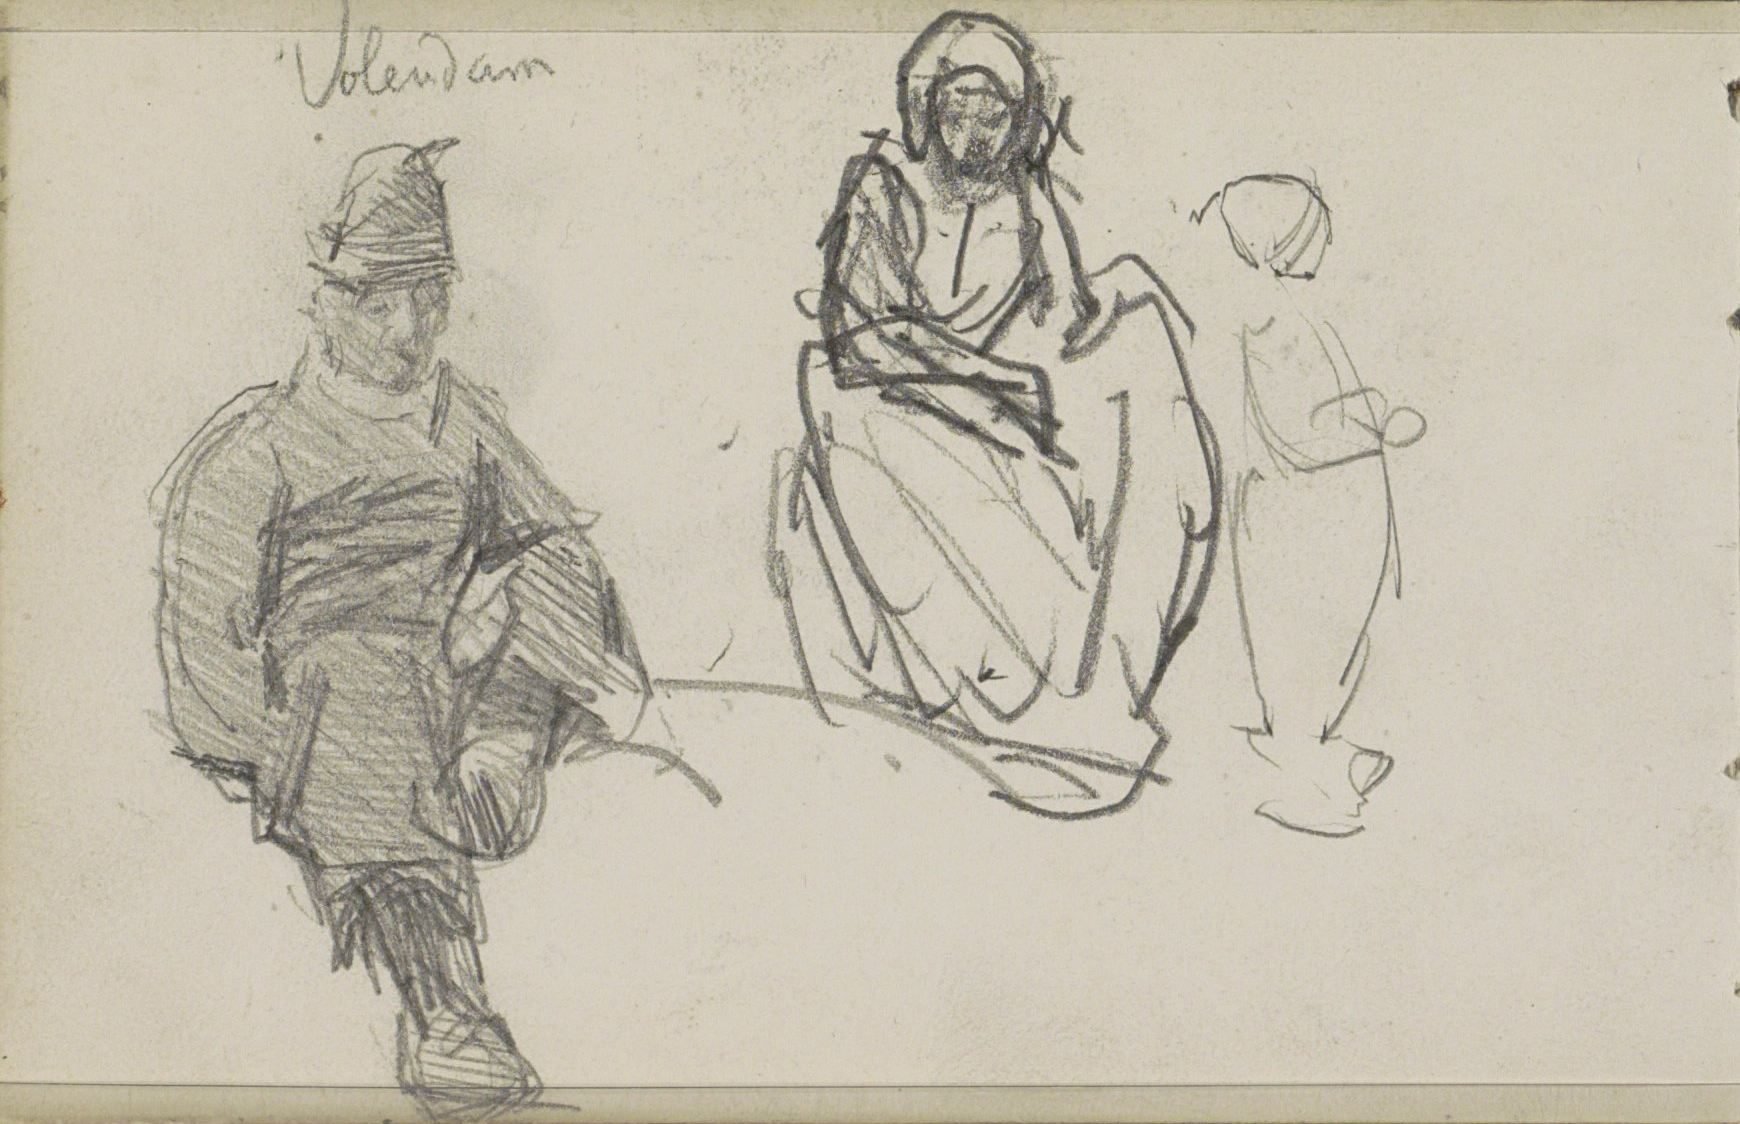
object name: sketchbook leaf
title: Zittende man en een vrouw met kind in Volendamse klederdracht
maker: george clausen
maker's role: draughtsman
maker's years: 1852-1912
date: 1875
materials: paper, pencil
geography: volendam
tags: adult woman, adult man, child, folk costume, regional costume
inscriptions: annotation: ‘Volendam’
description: Blad 6 verso uit een schetsboek met 38 bladen.